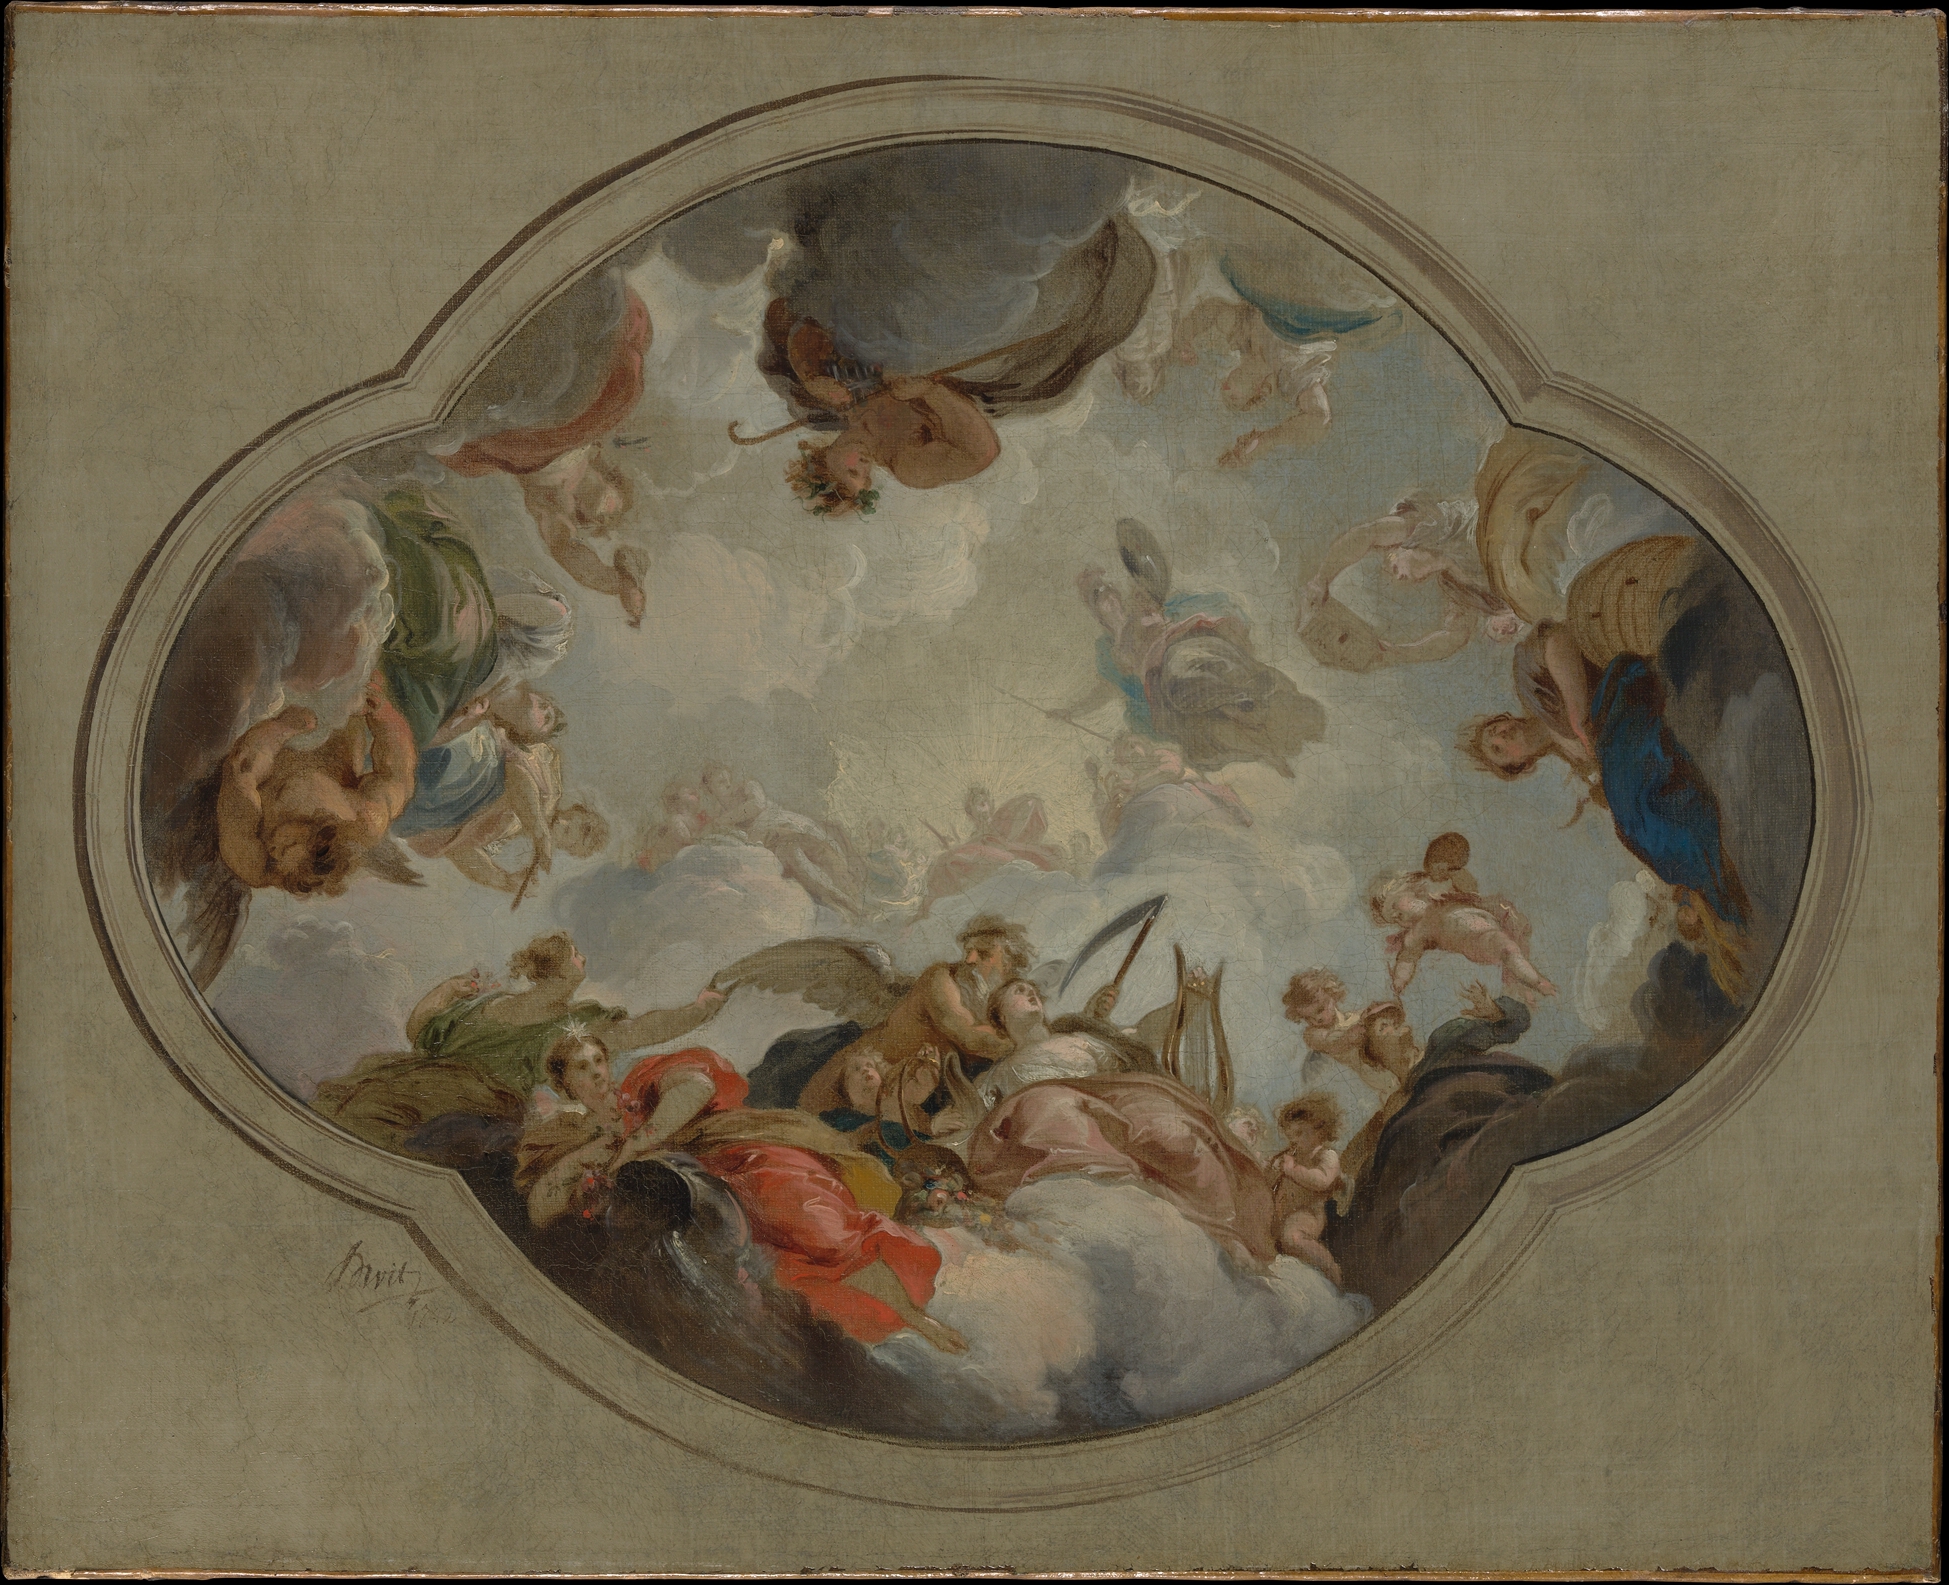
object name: painting, sketch for a ceiling painting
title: Allegory of the Arts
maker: jacob de wit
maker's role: artist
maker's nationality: dutch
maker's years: 1695-1754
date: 1742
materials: canvas, oil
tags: putti,sky,allegory